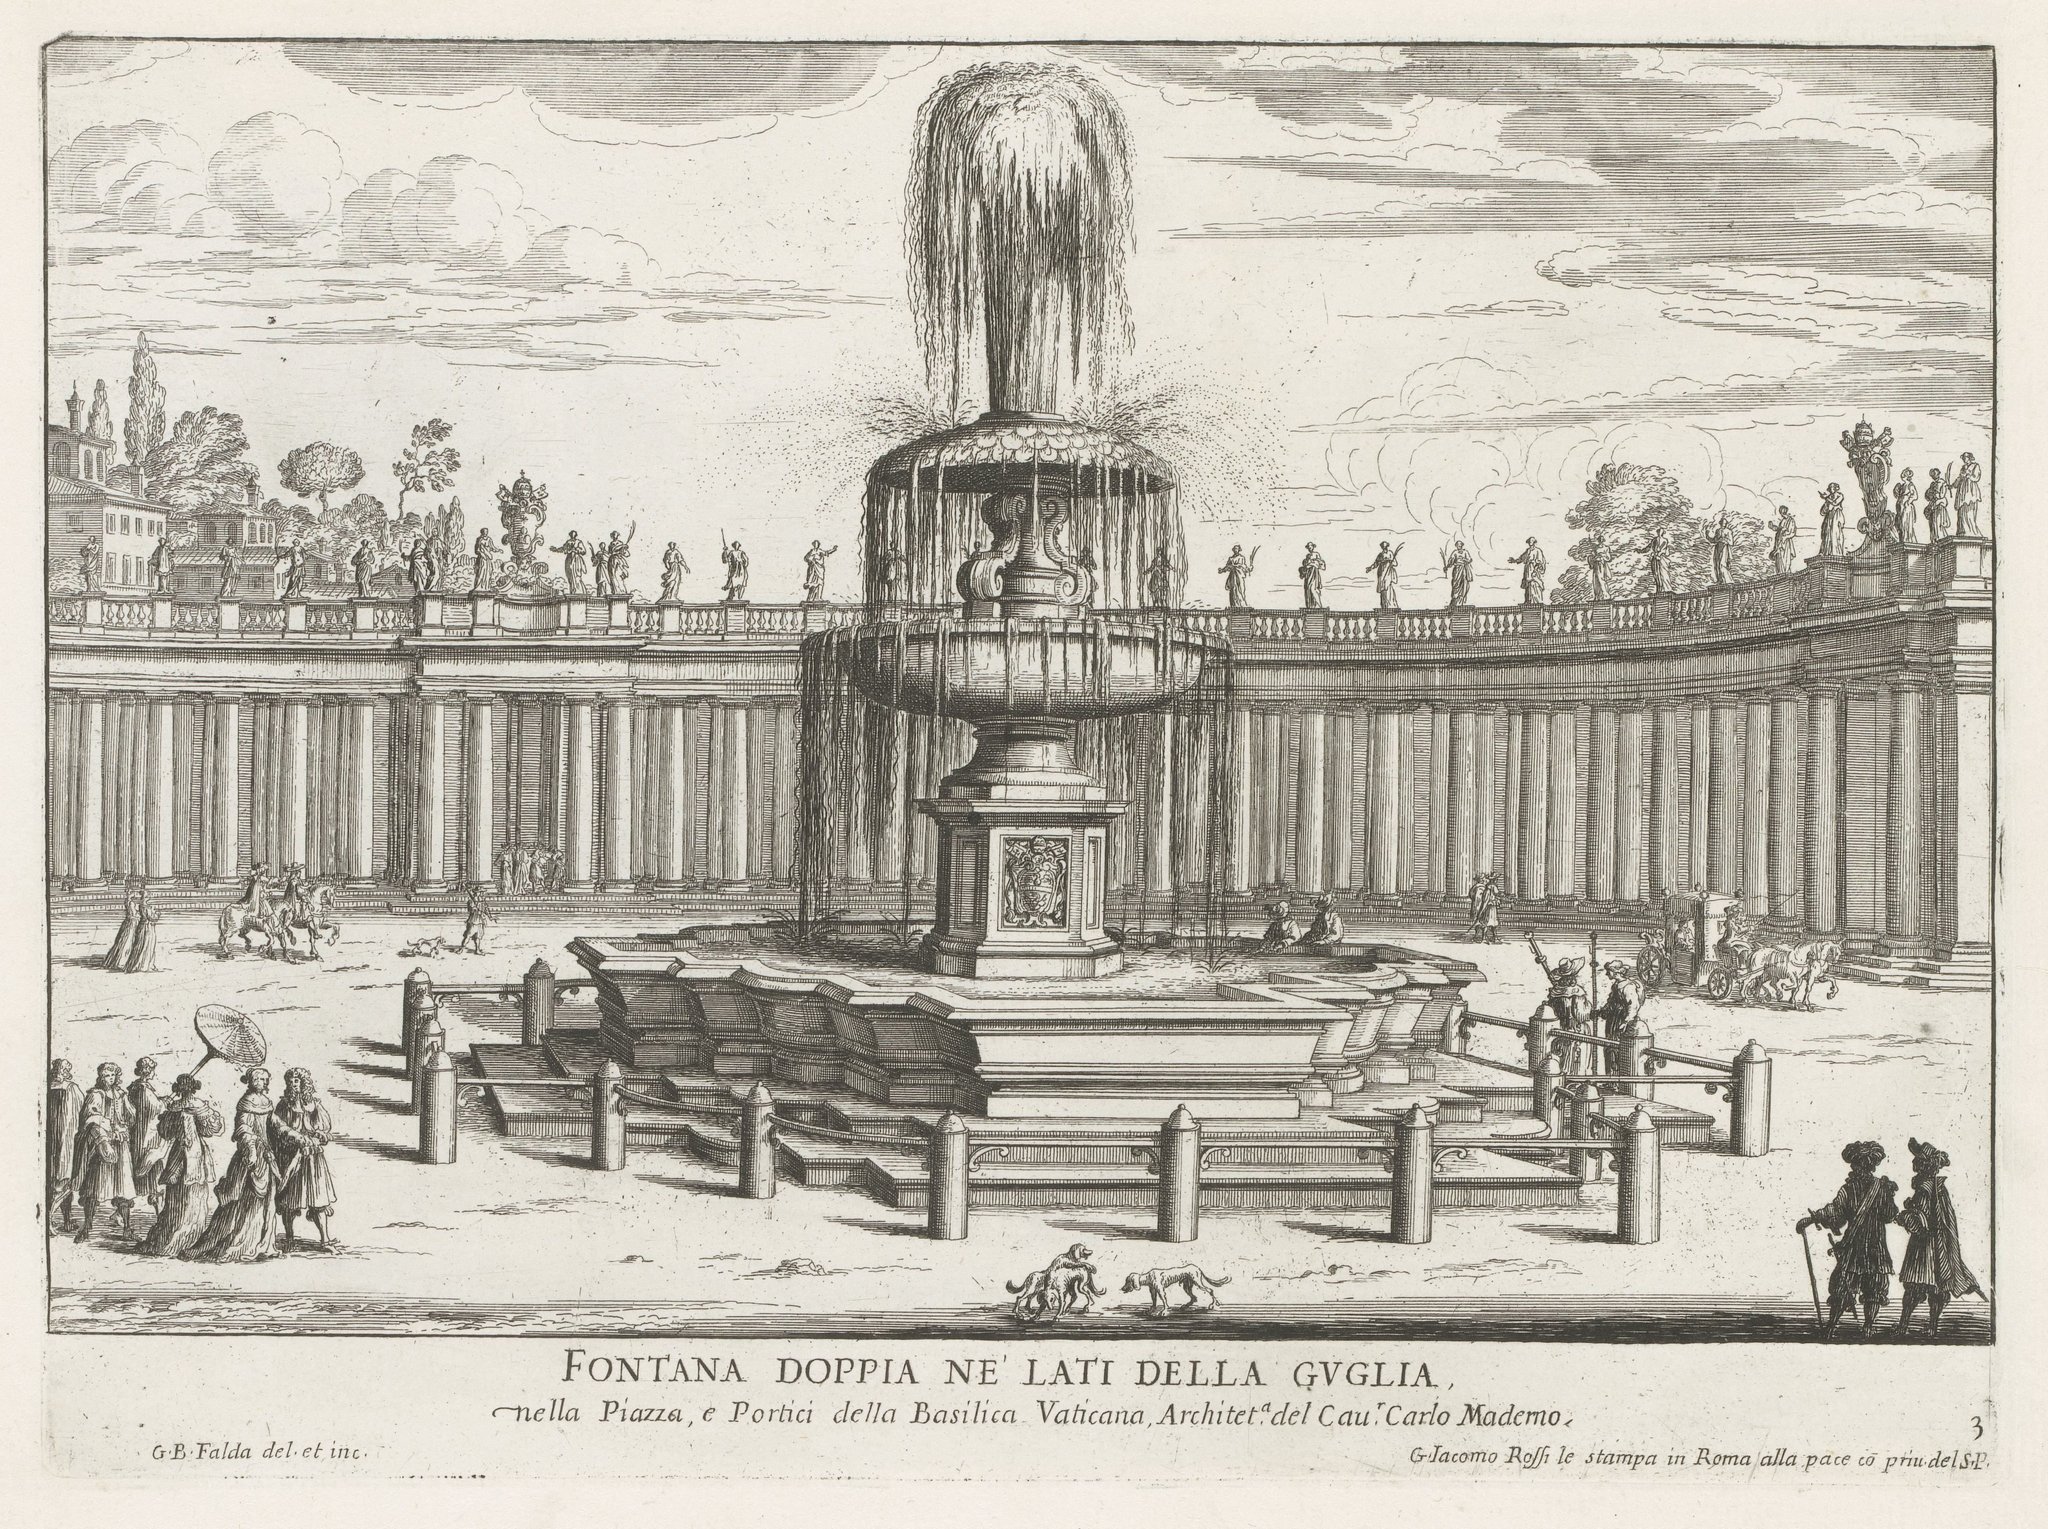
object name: print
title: Fontane di Roma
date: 1653-1691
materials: paper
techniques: etching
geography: rome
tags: ornamental fountain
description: Genummerd rechtsonder: 3. De prent maakt deel uit van een album.